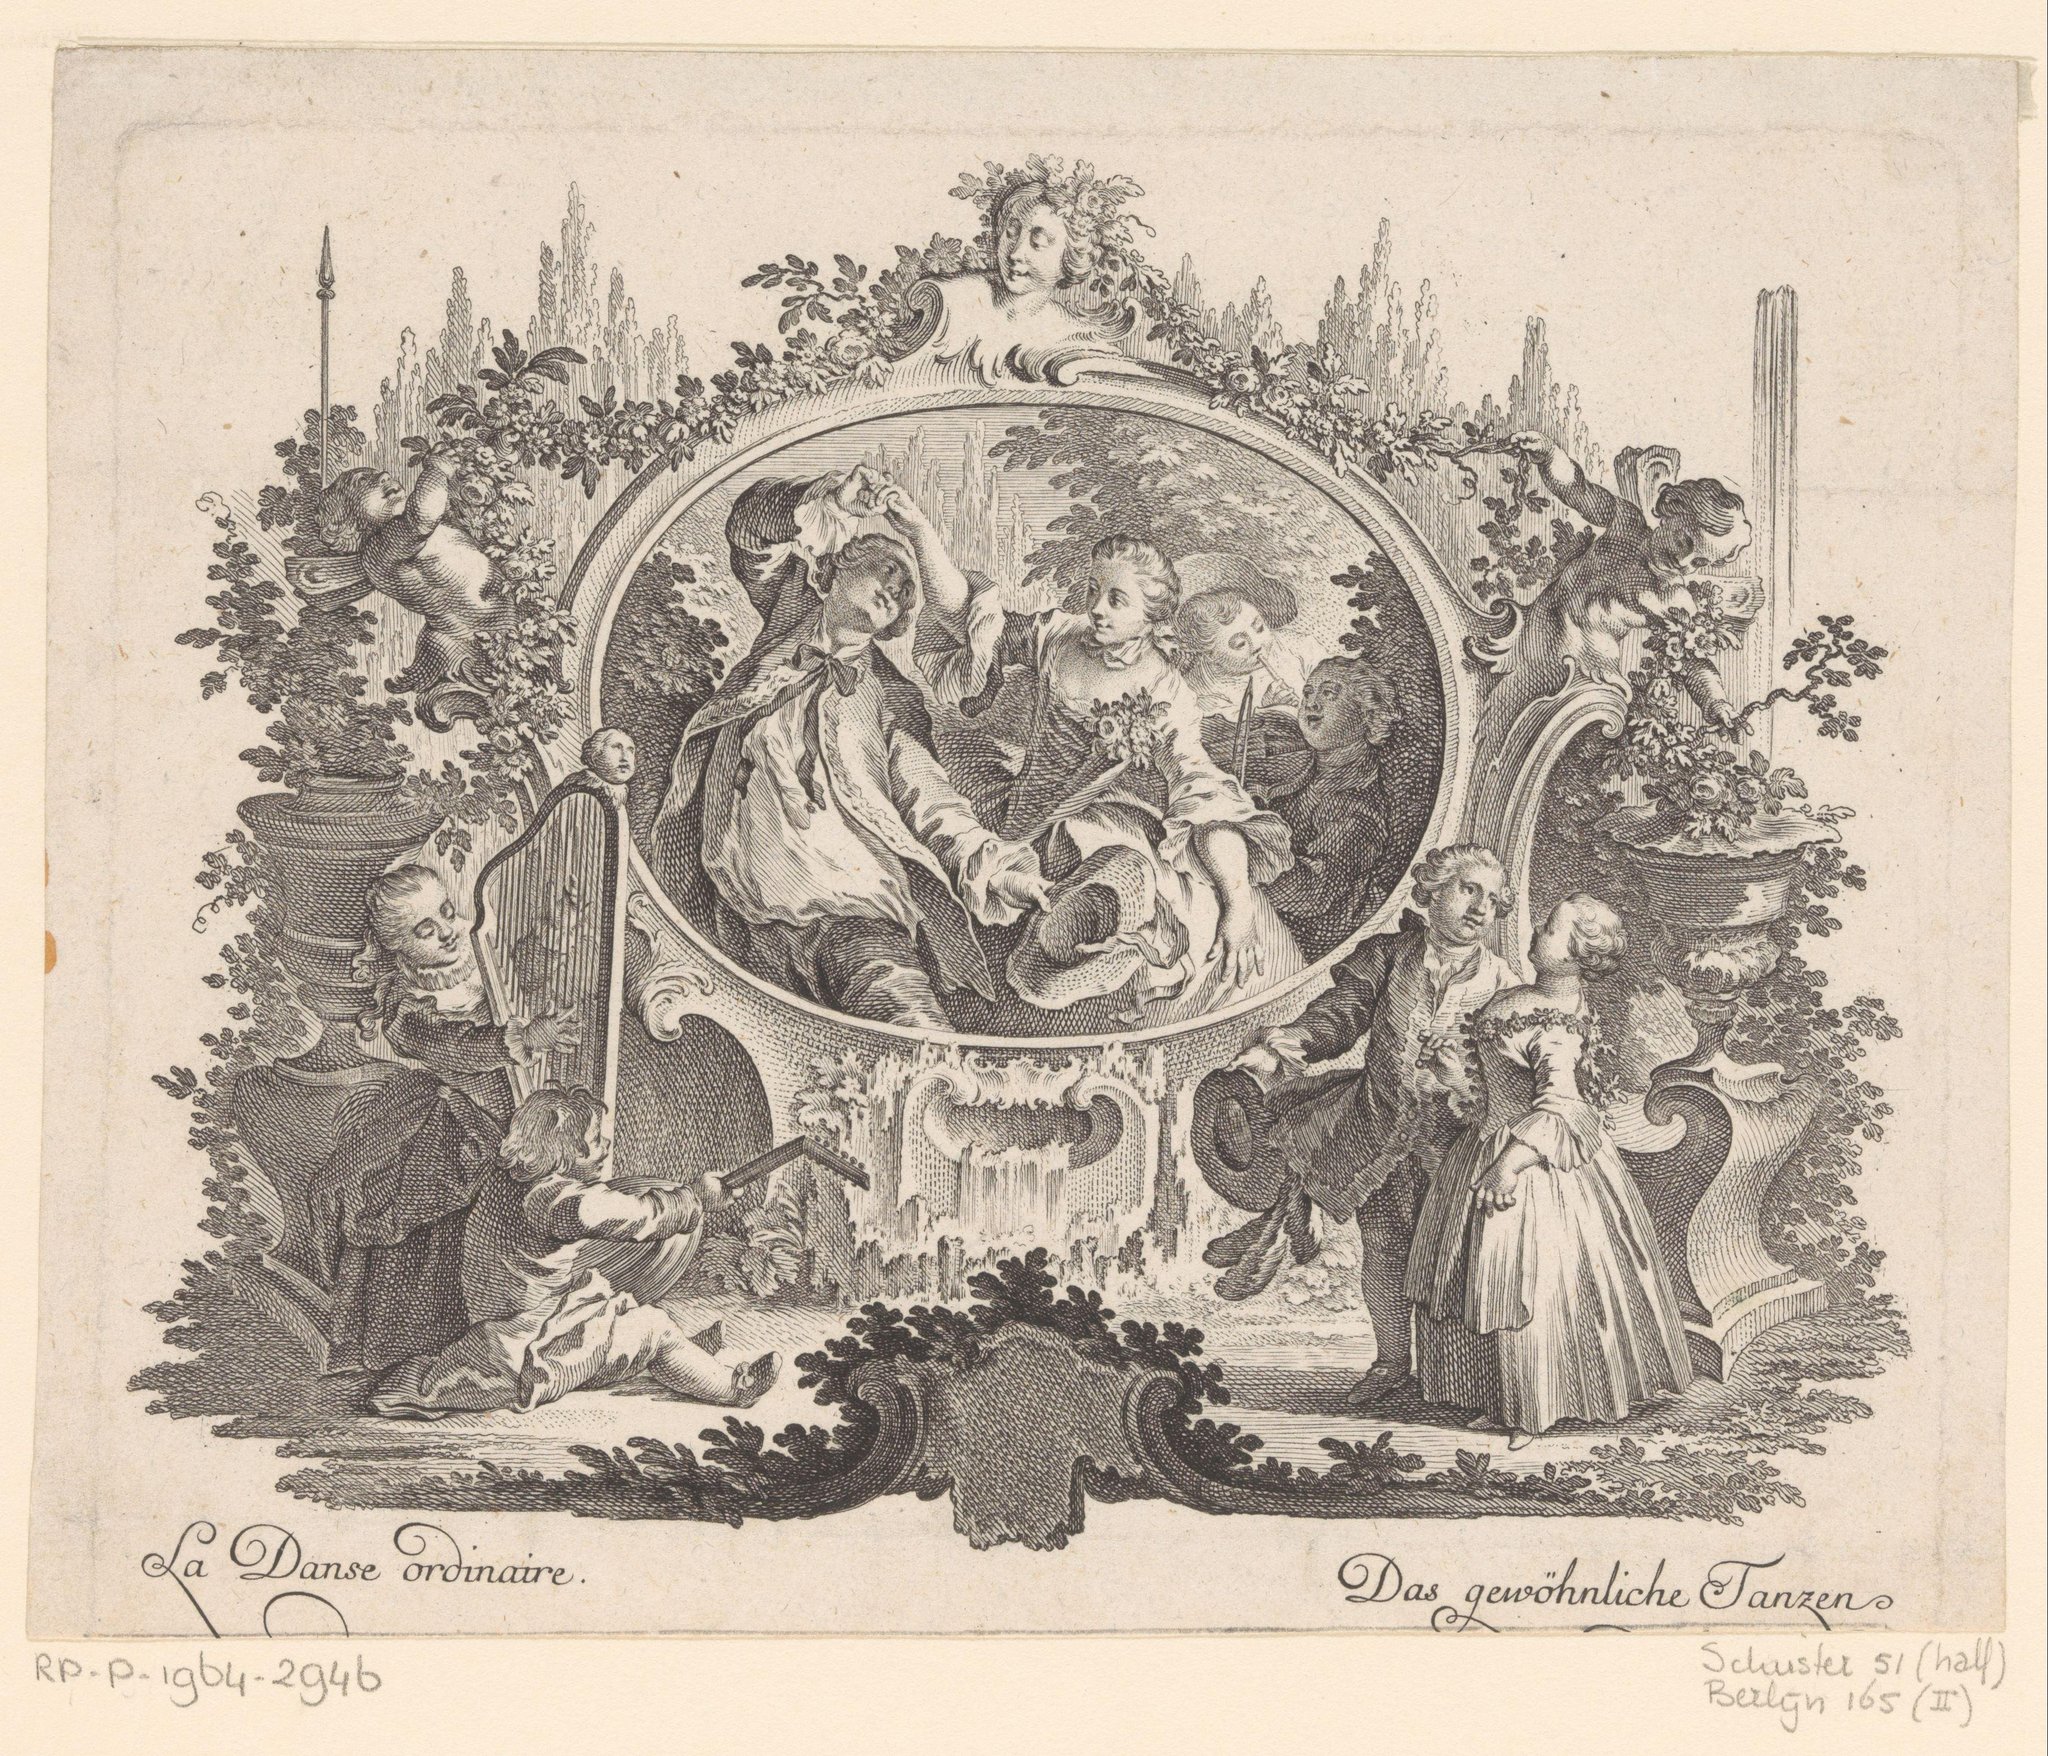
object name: print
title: Dansend paar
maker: johann esaias nilson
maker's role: draughtsman, print maker, publisher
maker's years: 1721-1788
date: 1731-1788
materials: paper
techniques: engraving, etching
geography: augsburg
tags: making music; musician with instrument, one pair dancing; man and woman dancing as a couple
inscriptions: collector's mark: Lugt 2228, collector's mark: Lugt 2760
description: De bovenste helft van een blad met twee scènes. Een man en vrouw dansen op de muziek van de twee muzikanten rechts. De voorstelling bevindt zich in een ovale lijst omgeven door rocaille ornamenten, putti en musicerende en dansende figuren.